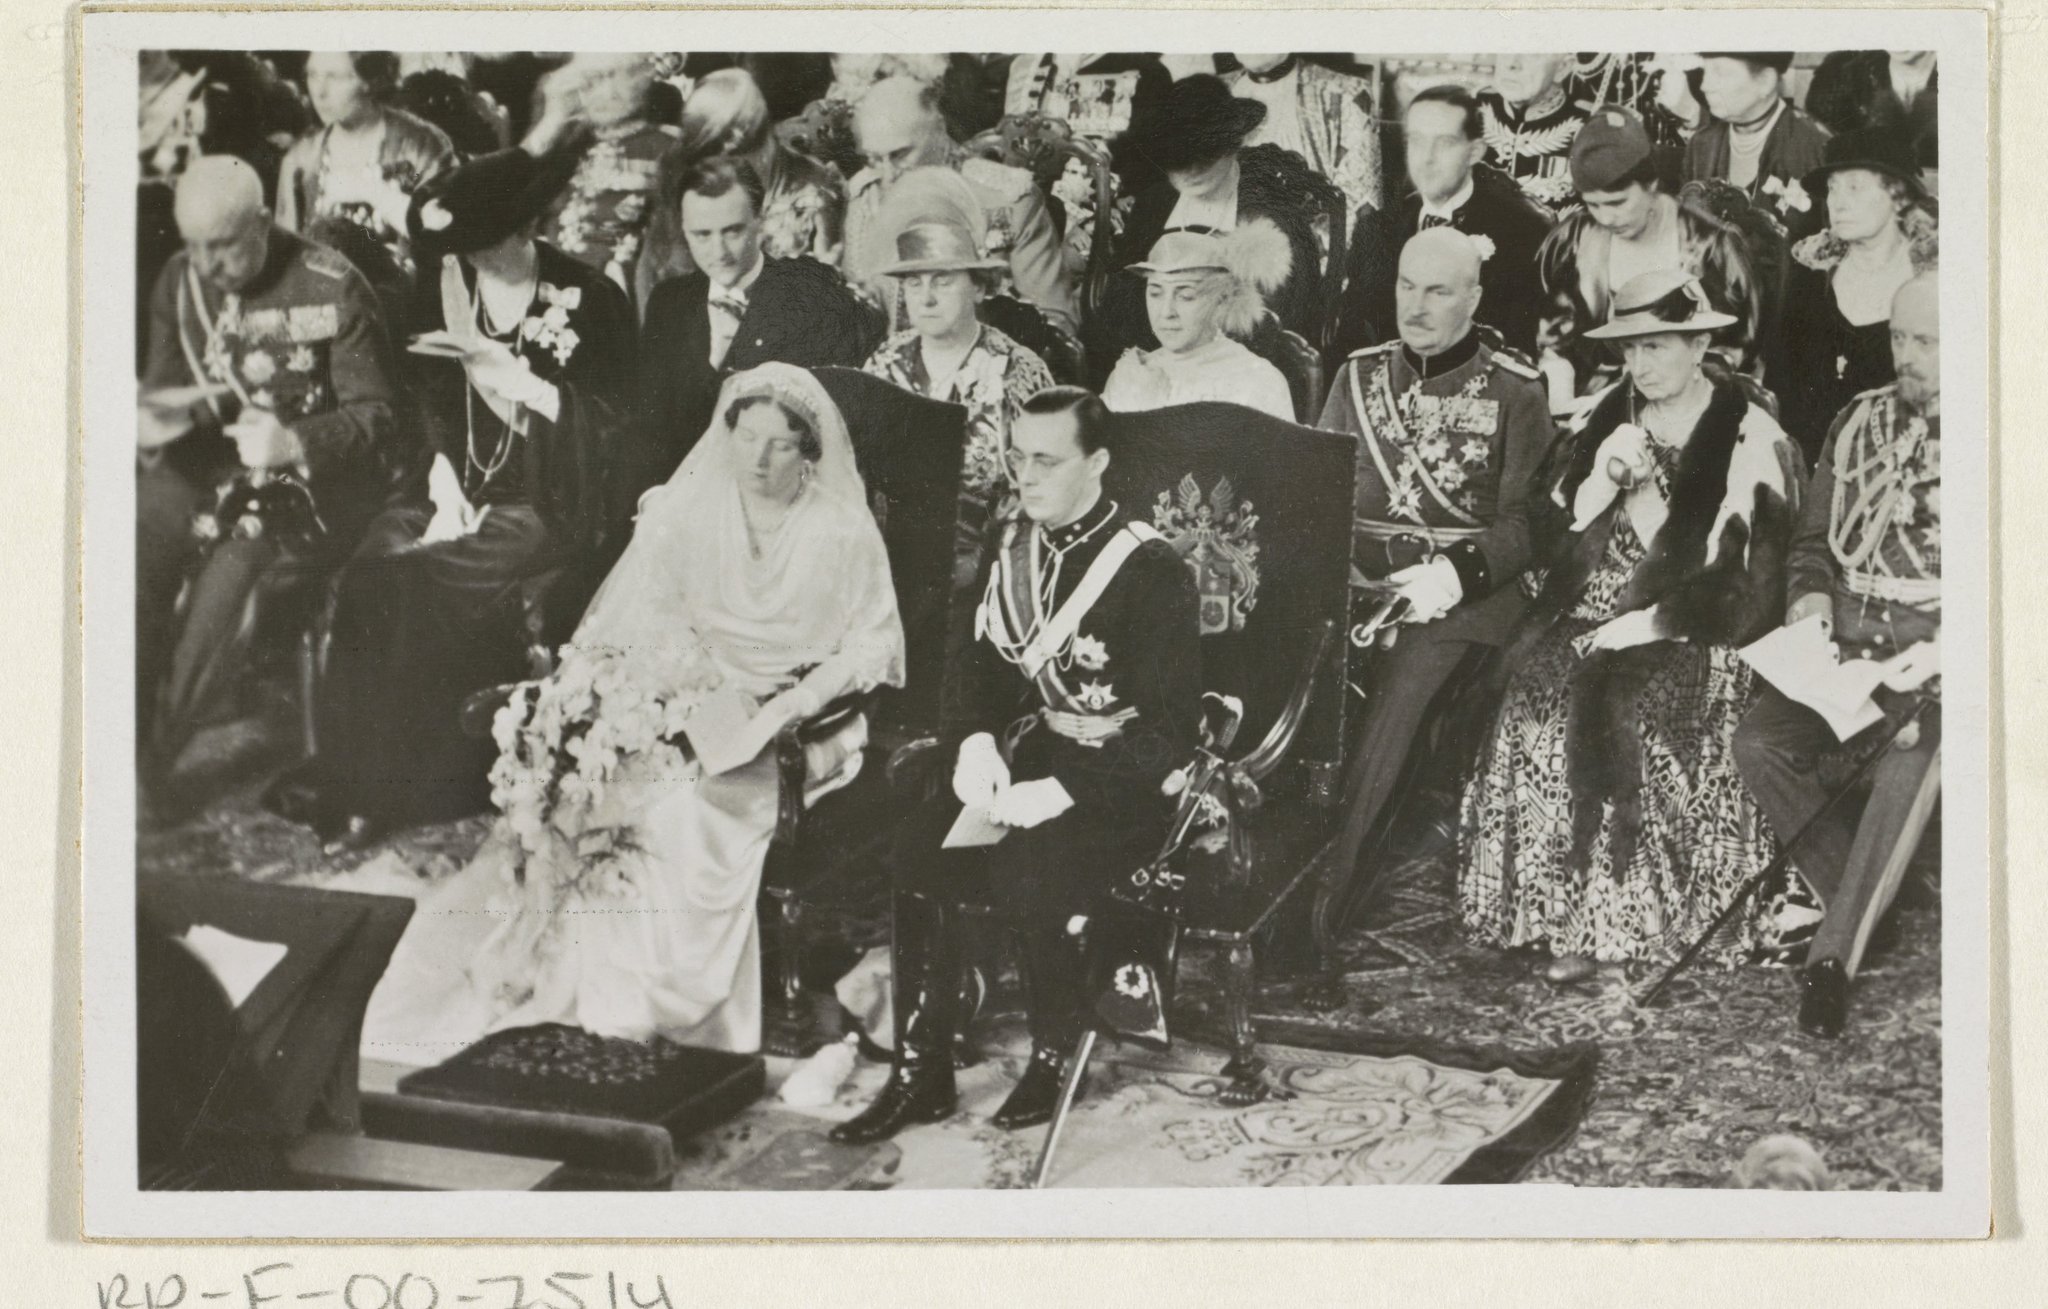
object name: photograph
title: Huwelijk van Juliana, koningin der Nederlanden, en Bernhard van Lippe-Biesterfeld in de Grote Kerk te Den Haag op 7 januari 1937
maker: Anonymous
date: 1937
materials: photographic support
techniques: photography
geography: netherlands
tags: utrecht, bernhard (prins der nederlanden), the hague, juliana of the netherlands, (civil) marriage ceremonies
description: De hier vermelde titel verwijst naar de hoogst verkregen titel van de geportretteerde, niet per se naar de titel die de geportretteerde op deze voorstelling draagt.